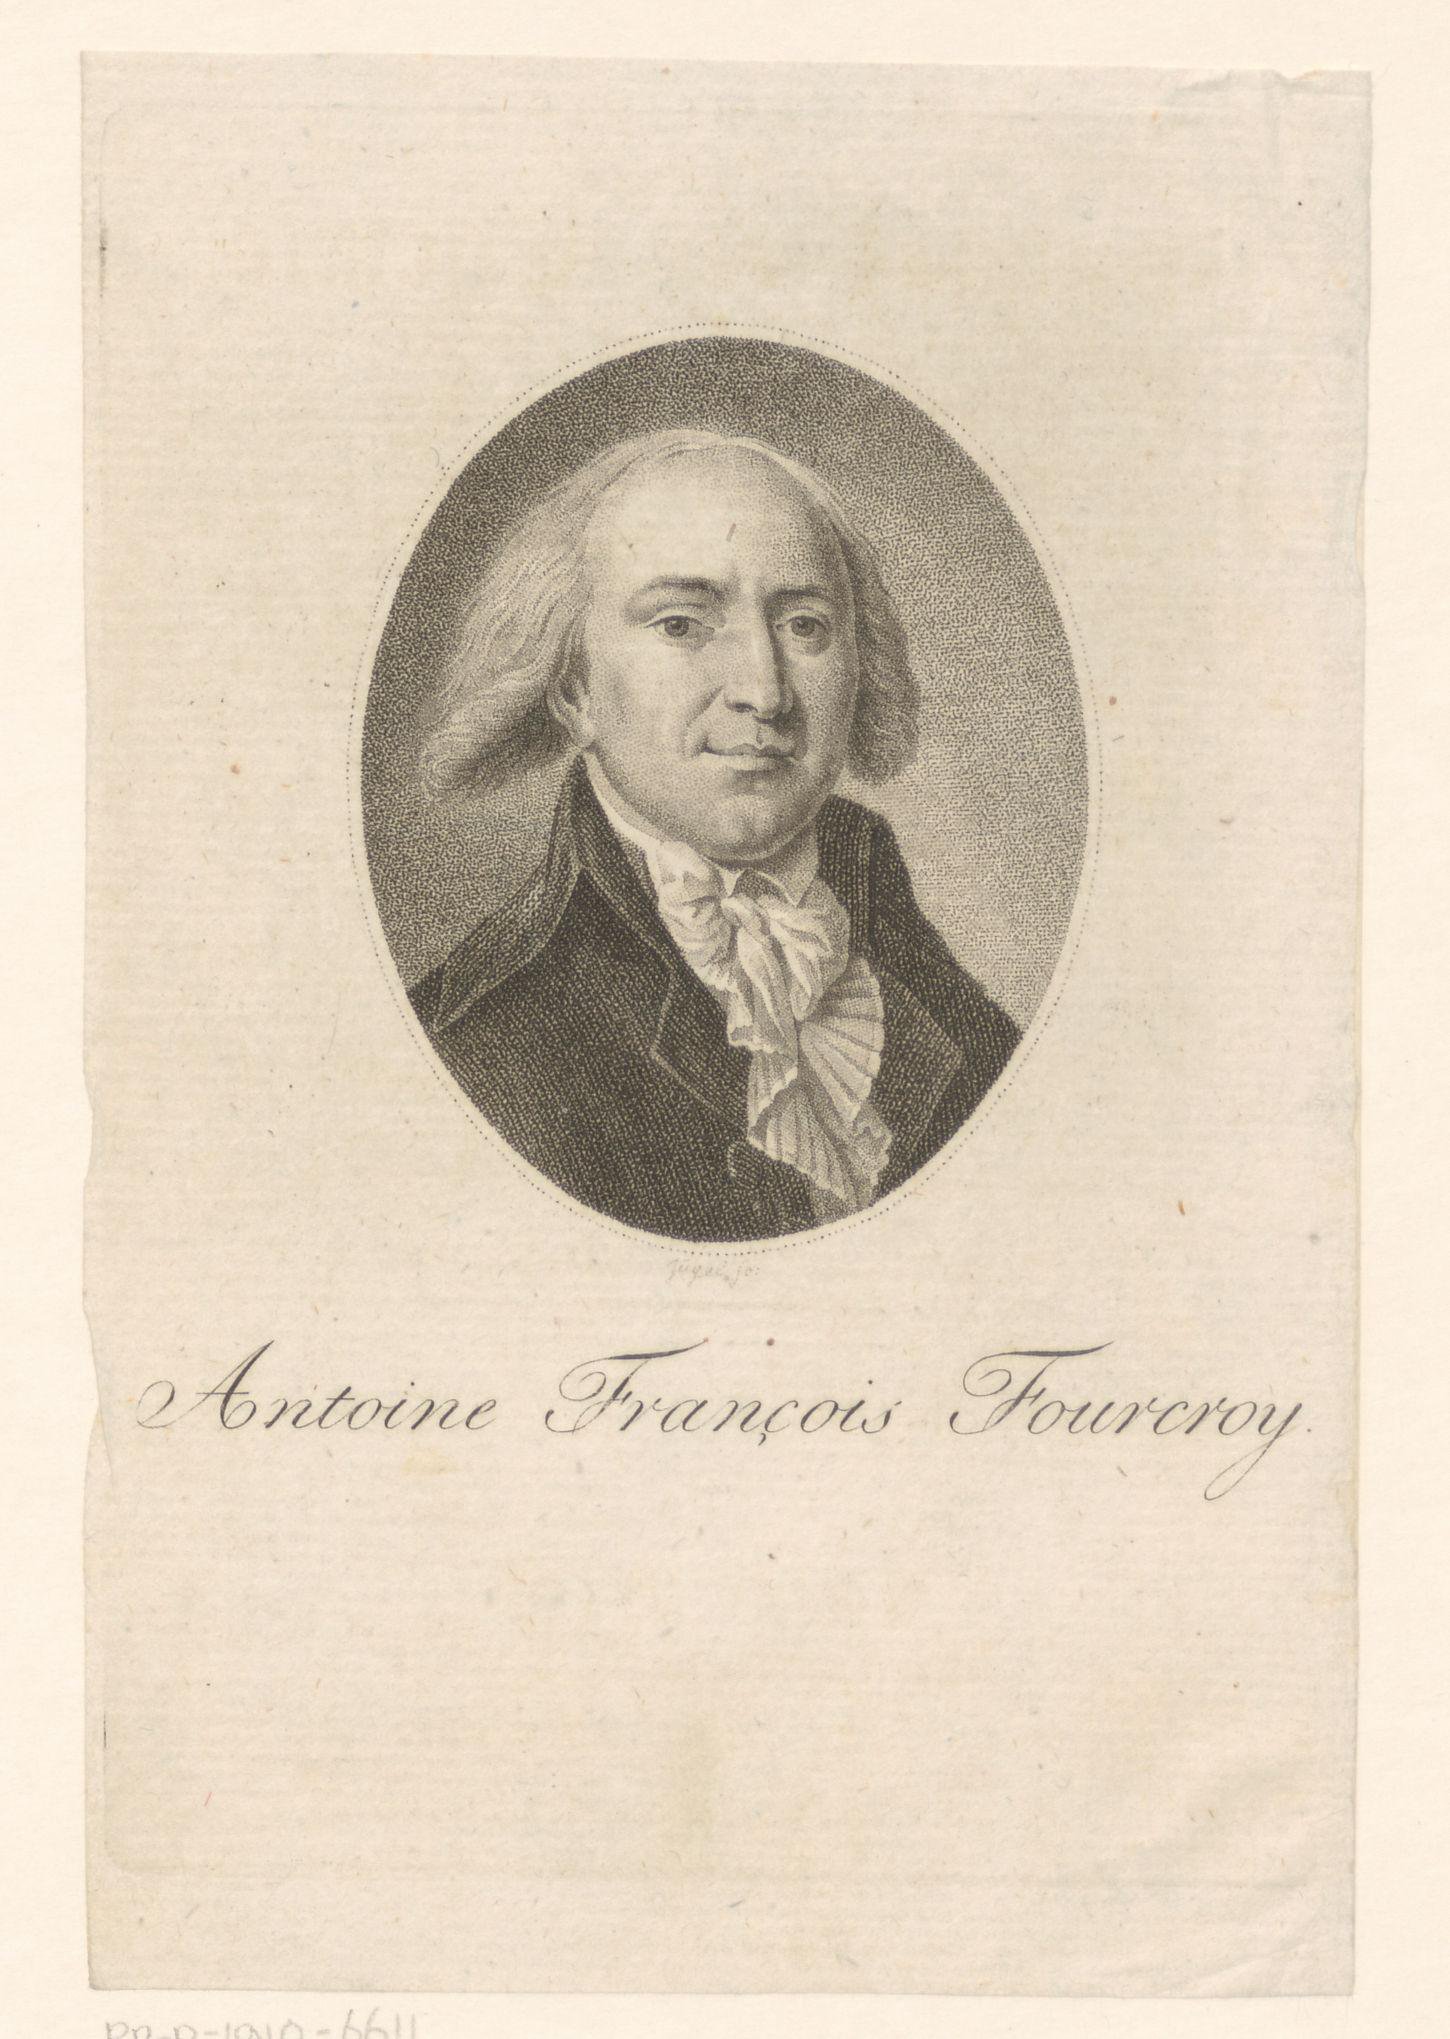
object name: print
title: Portret van Antoine François de Fourcroy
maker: friedrich jügel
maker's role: print maker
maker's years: 1772-1833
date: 1782-1833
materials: paper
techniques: stippling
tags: paris, politician, chemistry (+ portrait of scholar, scientist), historical persons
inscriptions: collector's mark: Lugt 2228